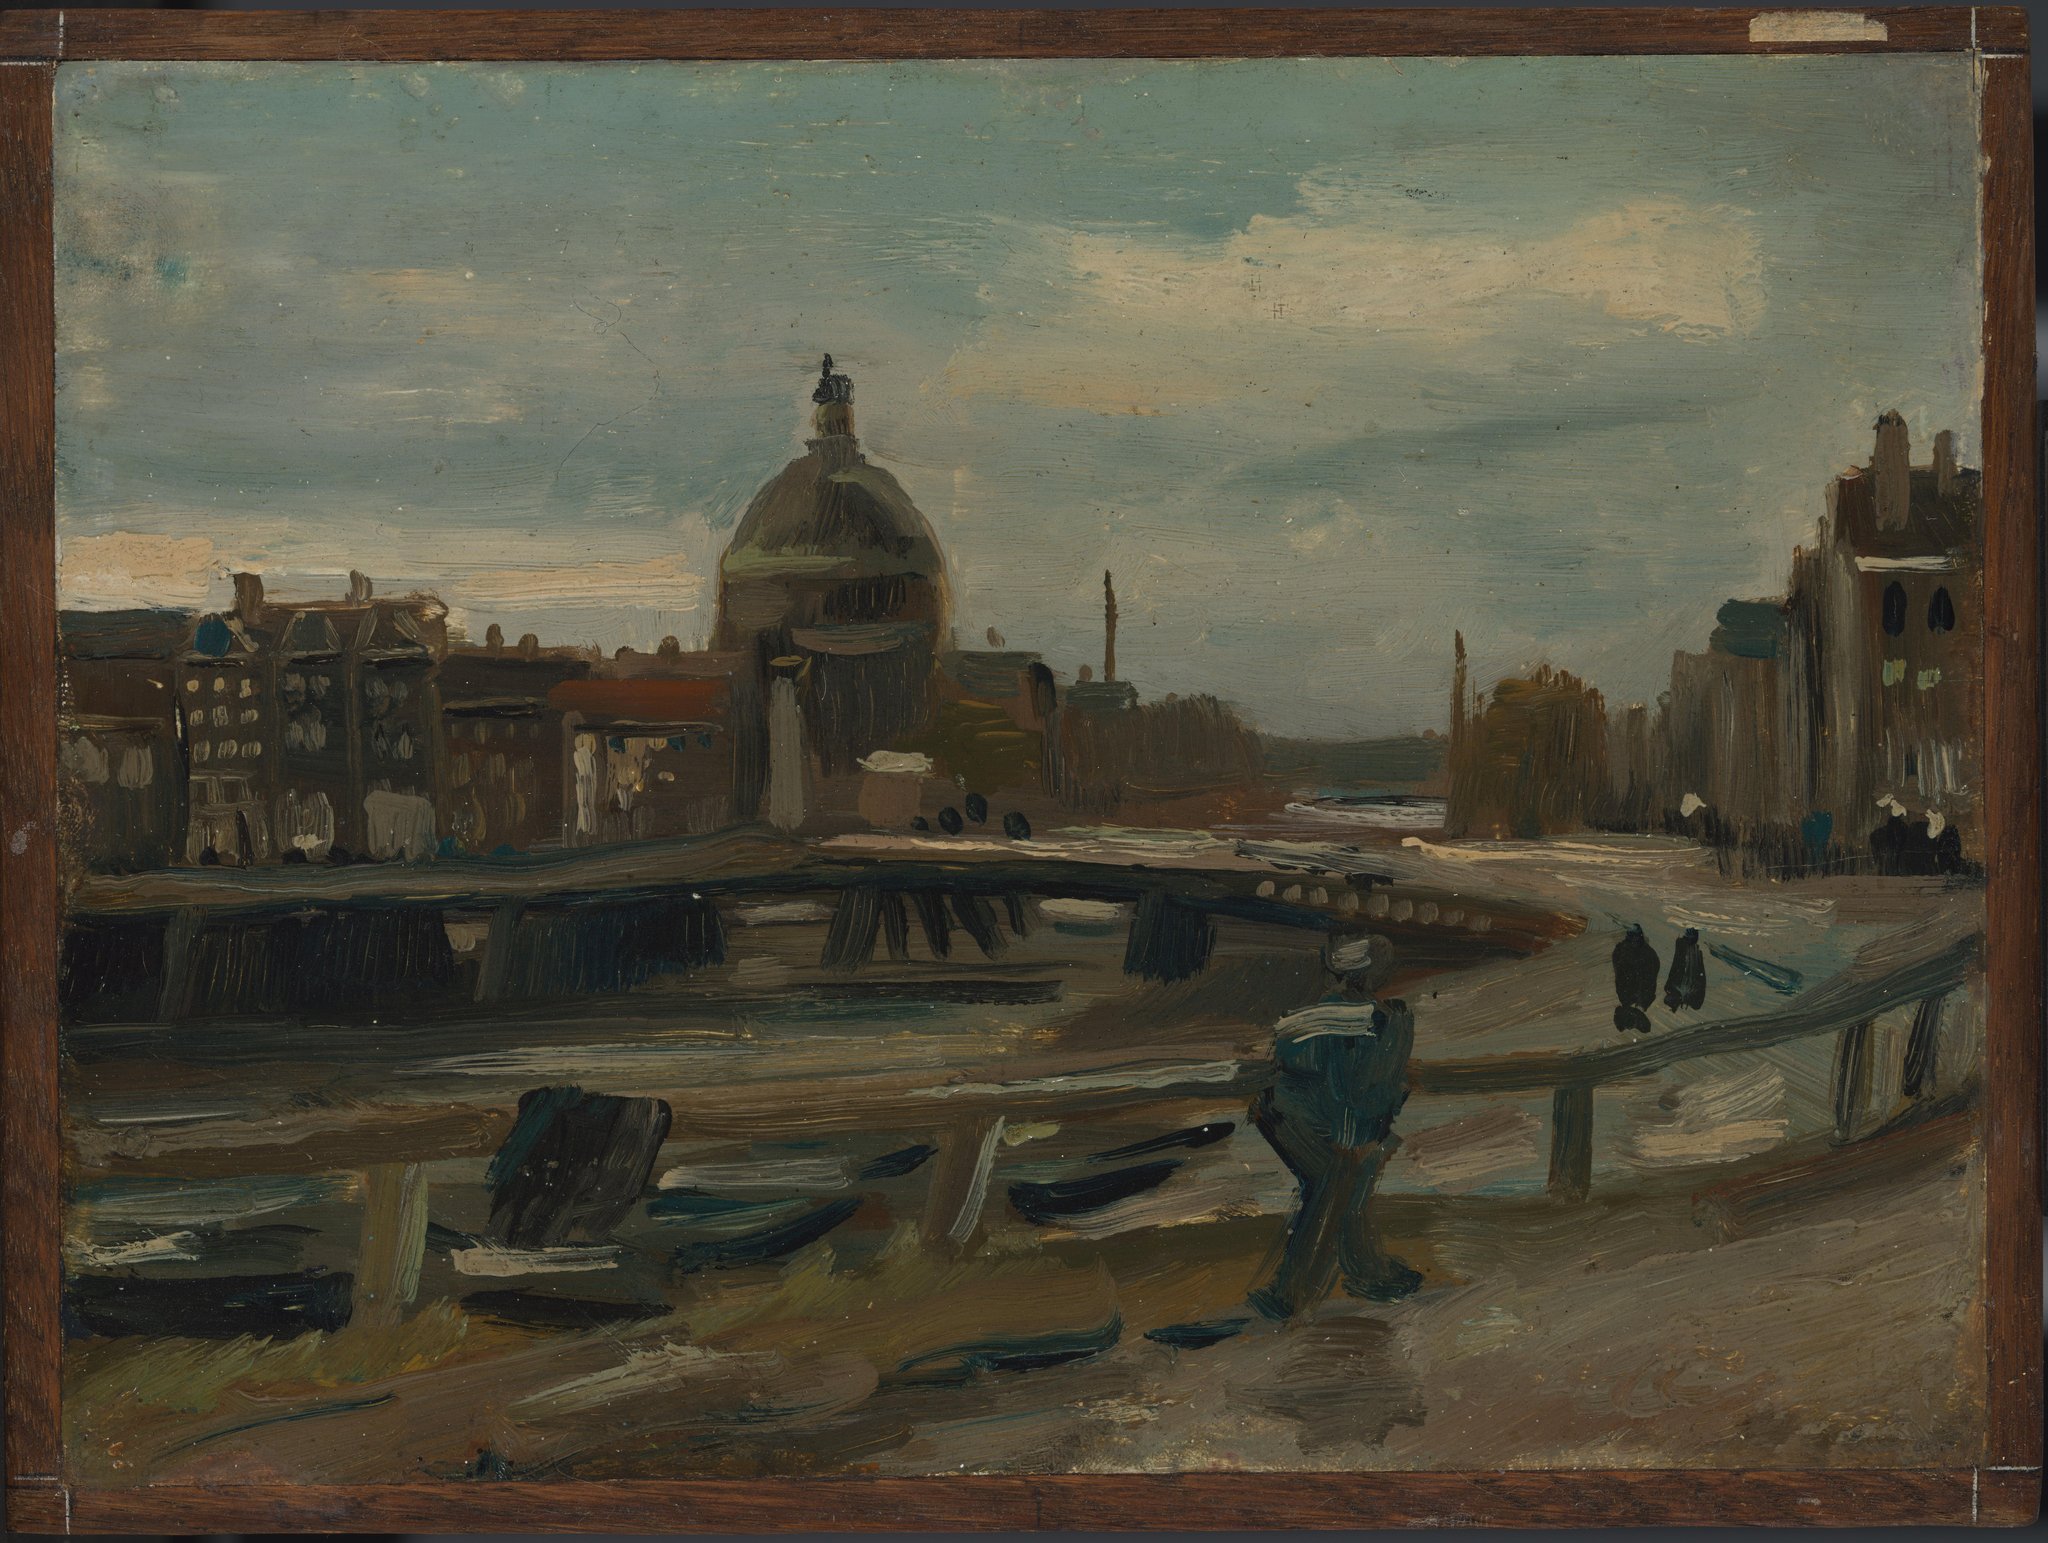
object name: painting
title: The Singel near the Lutheran Church in Amsterdam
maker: vincent van gogh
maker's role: draughtsman, painter, print maker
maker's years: 1853-1890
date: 1885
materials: oil, paint, panel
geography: amsterdam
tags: singel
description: Having saved money diligently, Van Gogh travelled to Amsterdam to visit the then newly opened Rijksmuseum. There he saw paintings by Frans Hals and Rembrandt. He was so impressed by their loose brushwork that he painted this view of the Singel. He had brought a small panel and a painting box with him and immortalized this view with quick strokes of paint.